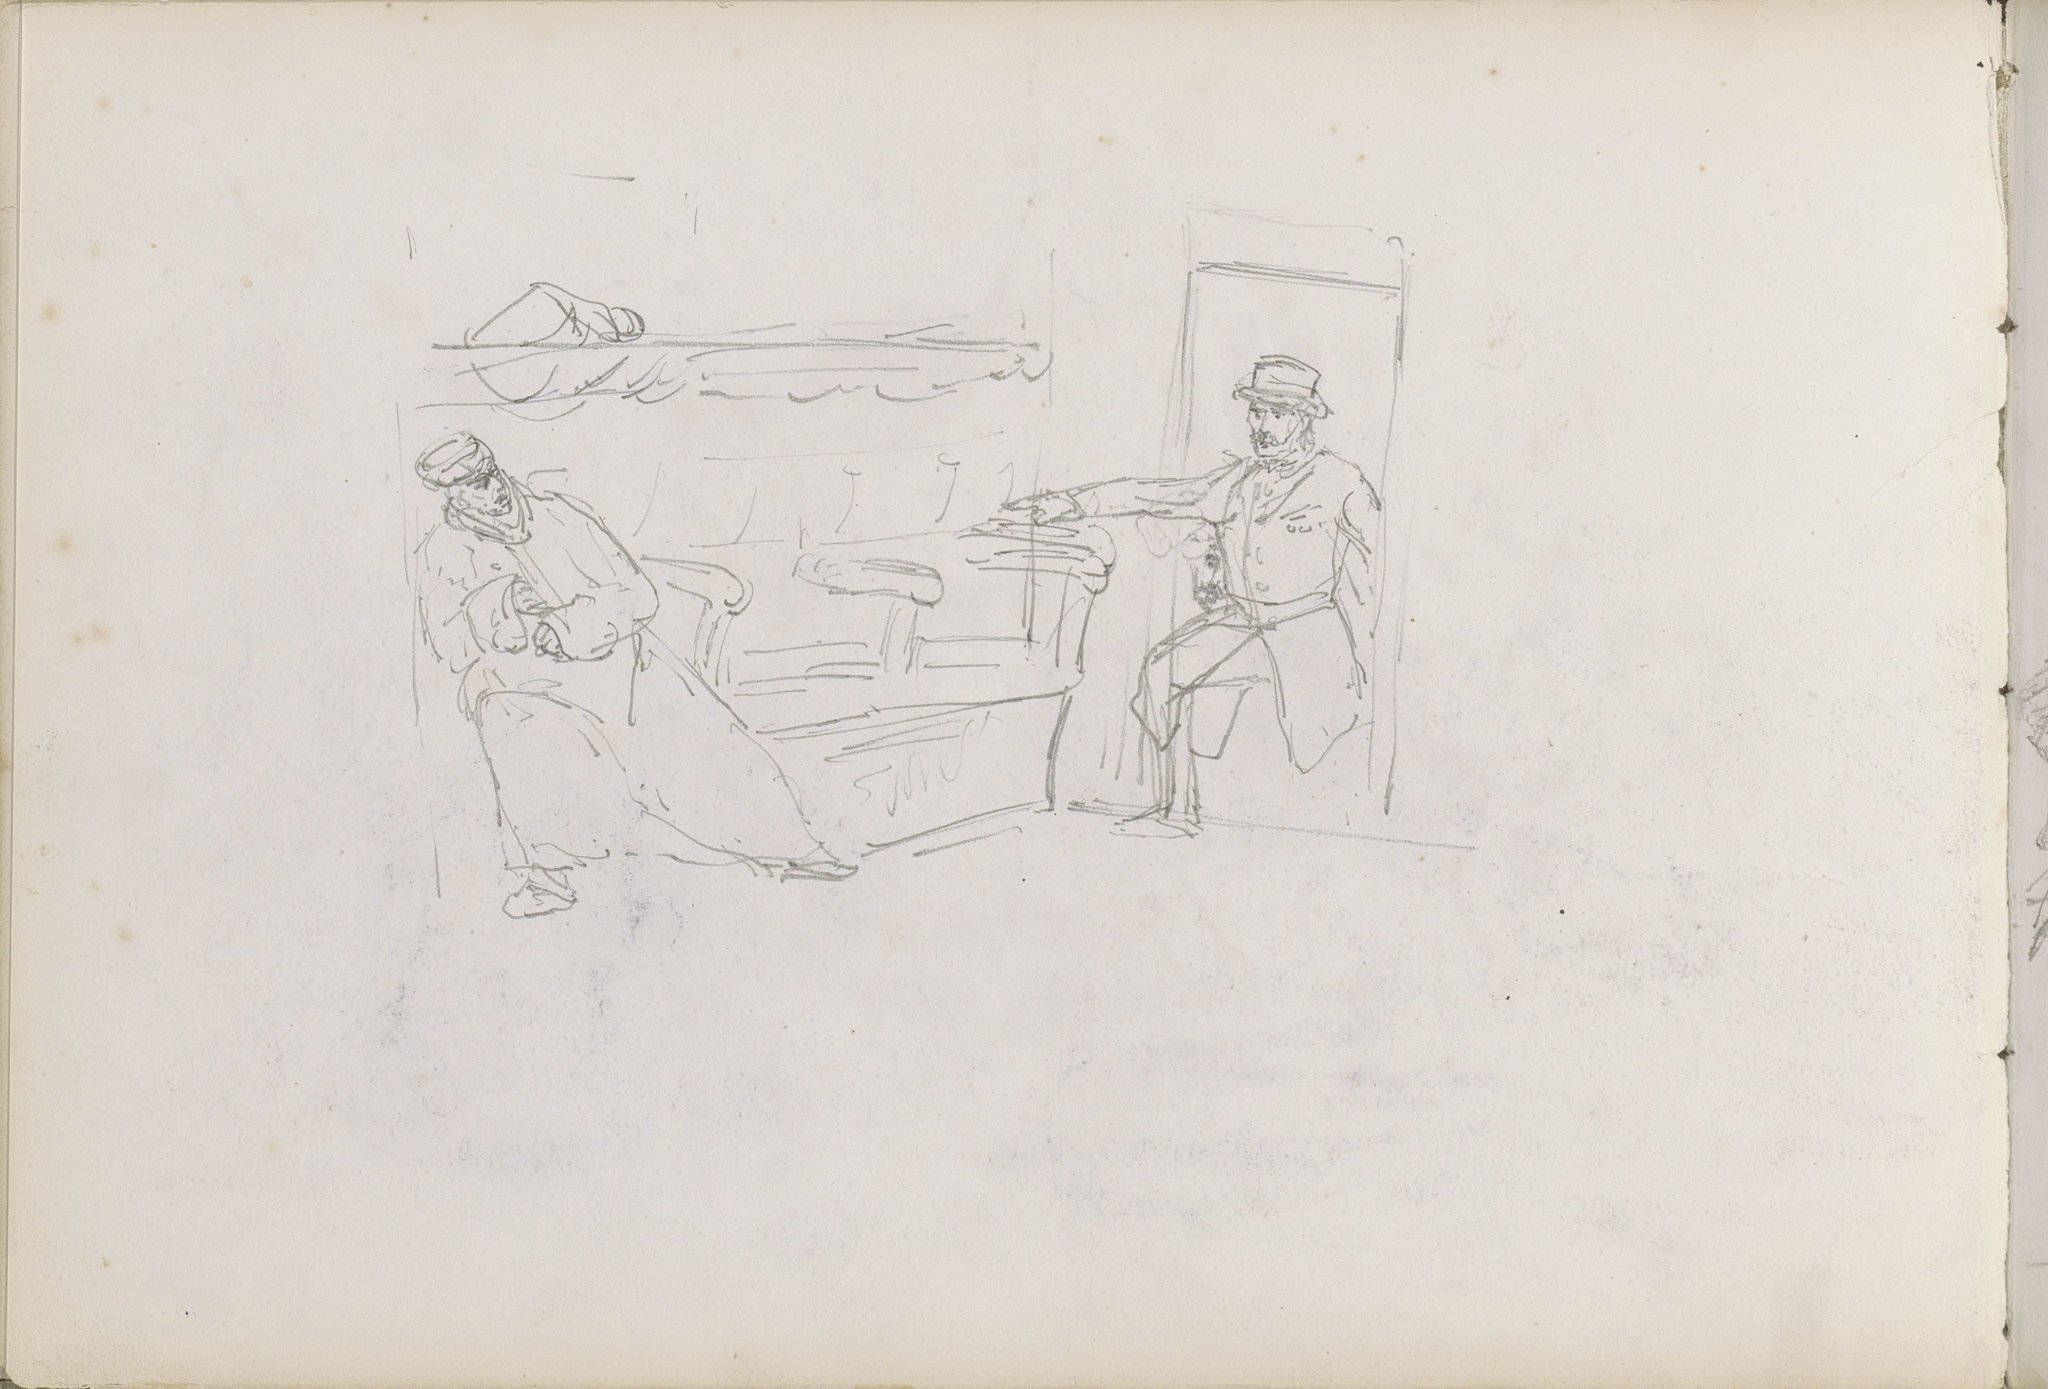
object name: sketchbook leaf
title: Twee mannen in een treincoupé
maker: george hendrik breitner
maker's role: draughtsman, painter, print maker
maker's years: 1857-1923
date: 1873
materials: paper, pencil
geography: rotterdam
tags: adult man (+ two persons), passenger train, division of armed forces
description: Blad 2 verso uit een schetsboek met 25 bladen.